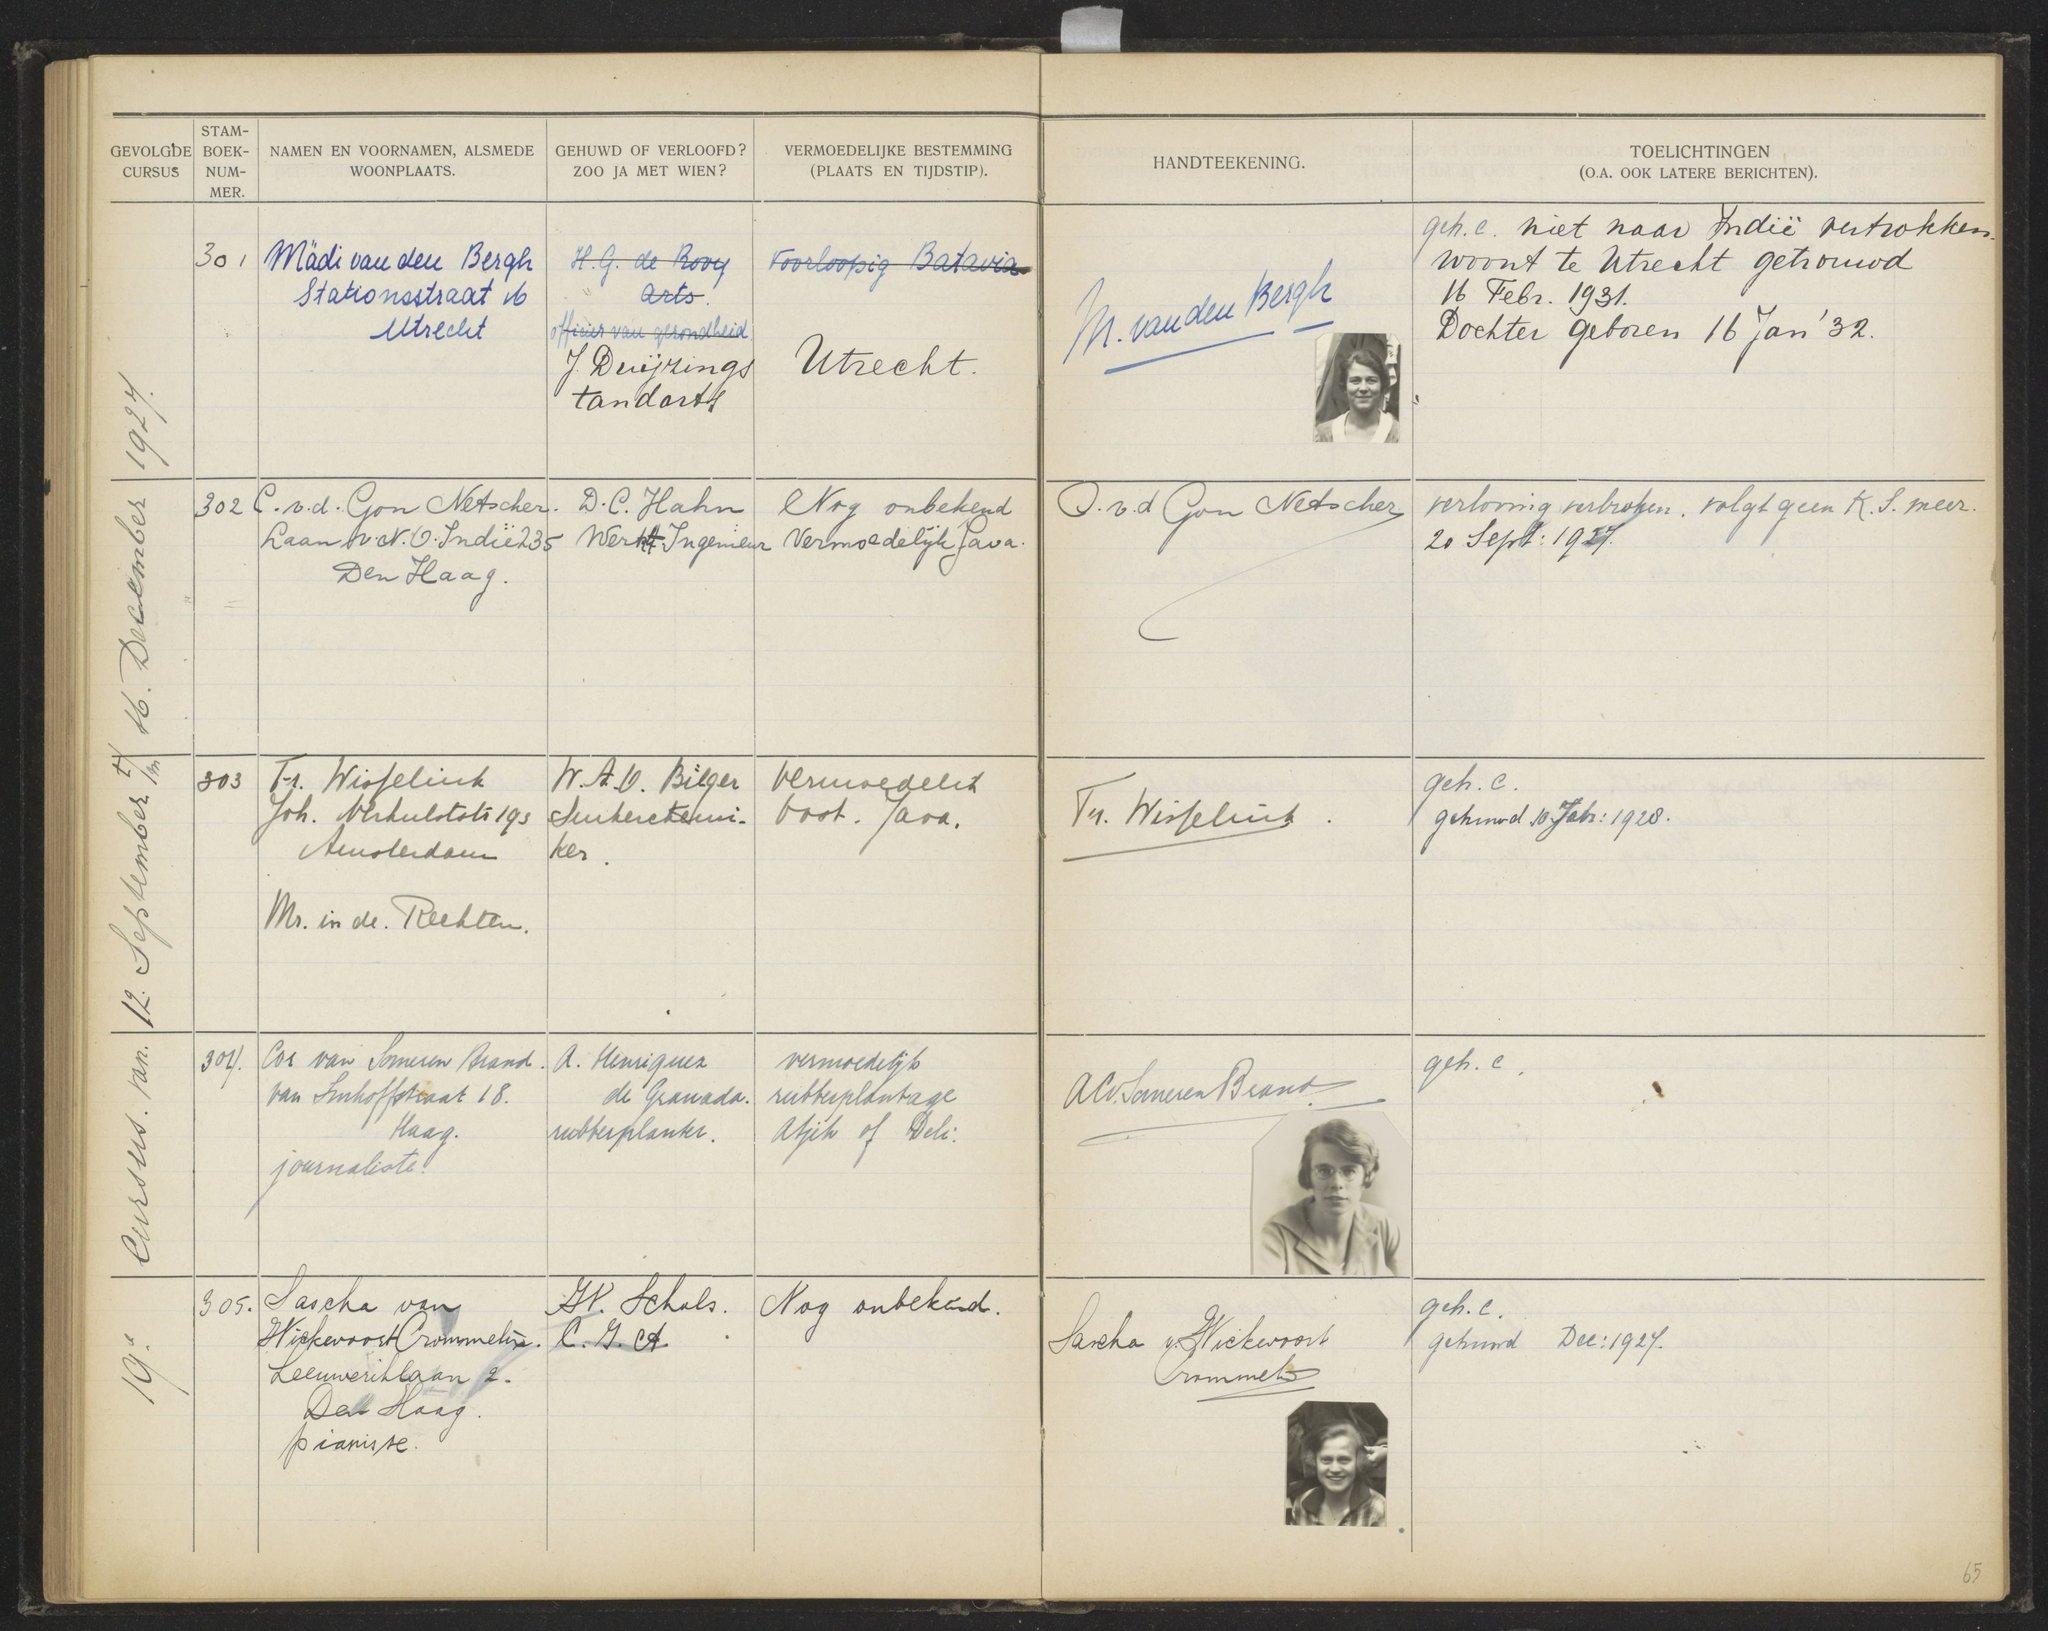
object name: photograph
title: Blad 65 uit Stamboek van de leerlingen der Koloniale School voor Meisjes en Vrouwen te 's-Gravenhage deel I (1921-1929)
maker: Anonymous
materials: paper, photographic support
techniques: photography, printing, writing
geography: the hague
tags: further education (+ pupil), further education, the hague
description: Twee pagina's met gegevens van de deelnemers aan de 19e driemaandelijkse cursus van 12 september tot en met 16 december 1927, stamboeknummers 301 tot en met 305. Onderdeel van Stamboek van de leerlingen der Koloniale School voor Meisjes en Vrouwen te 's-Gravenhage deel I (1921-1929).